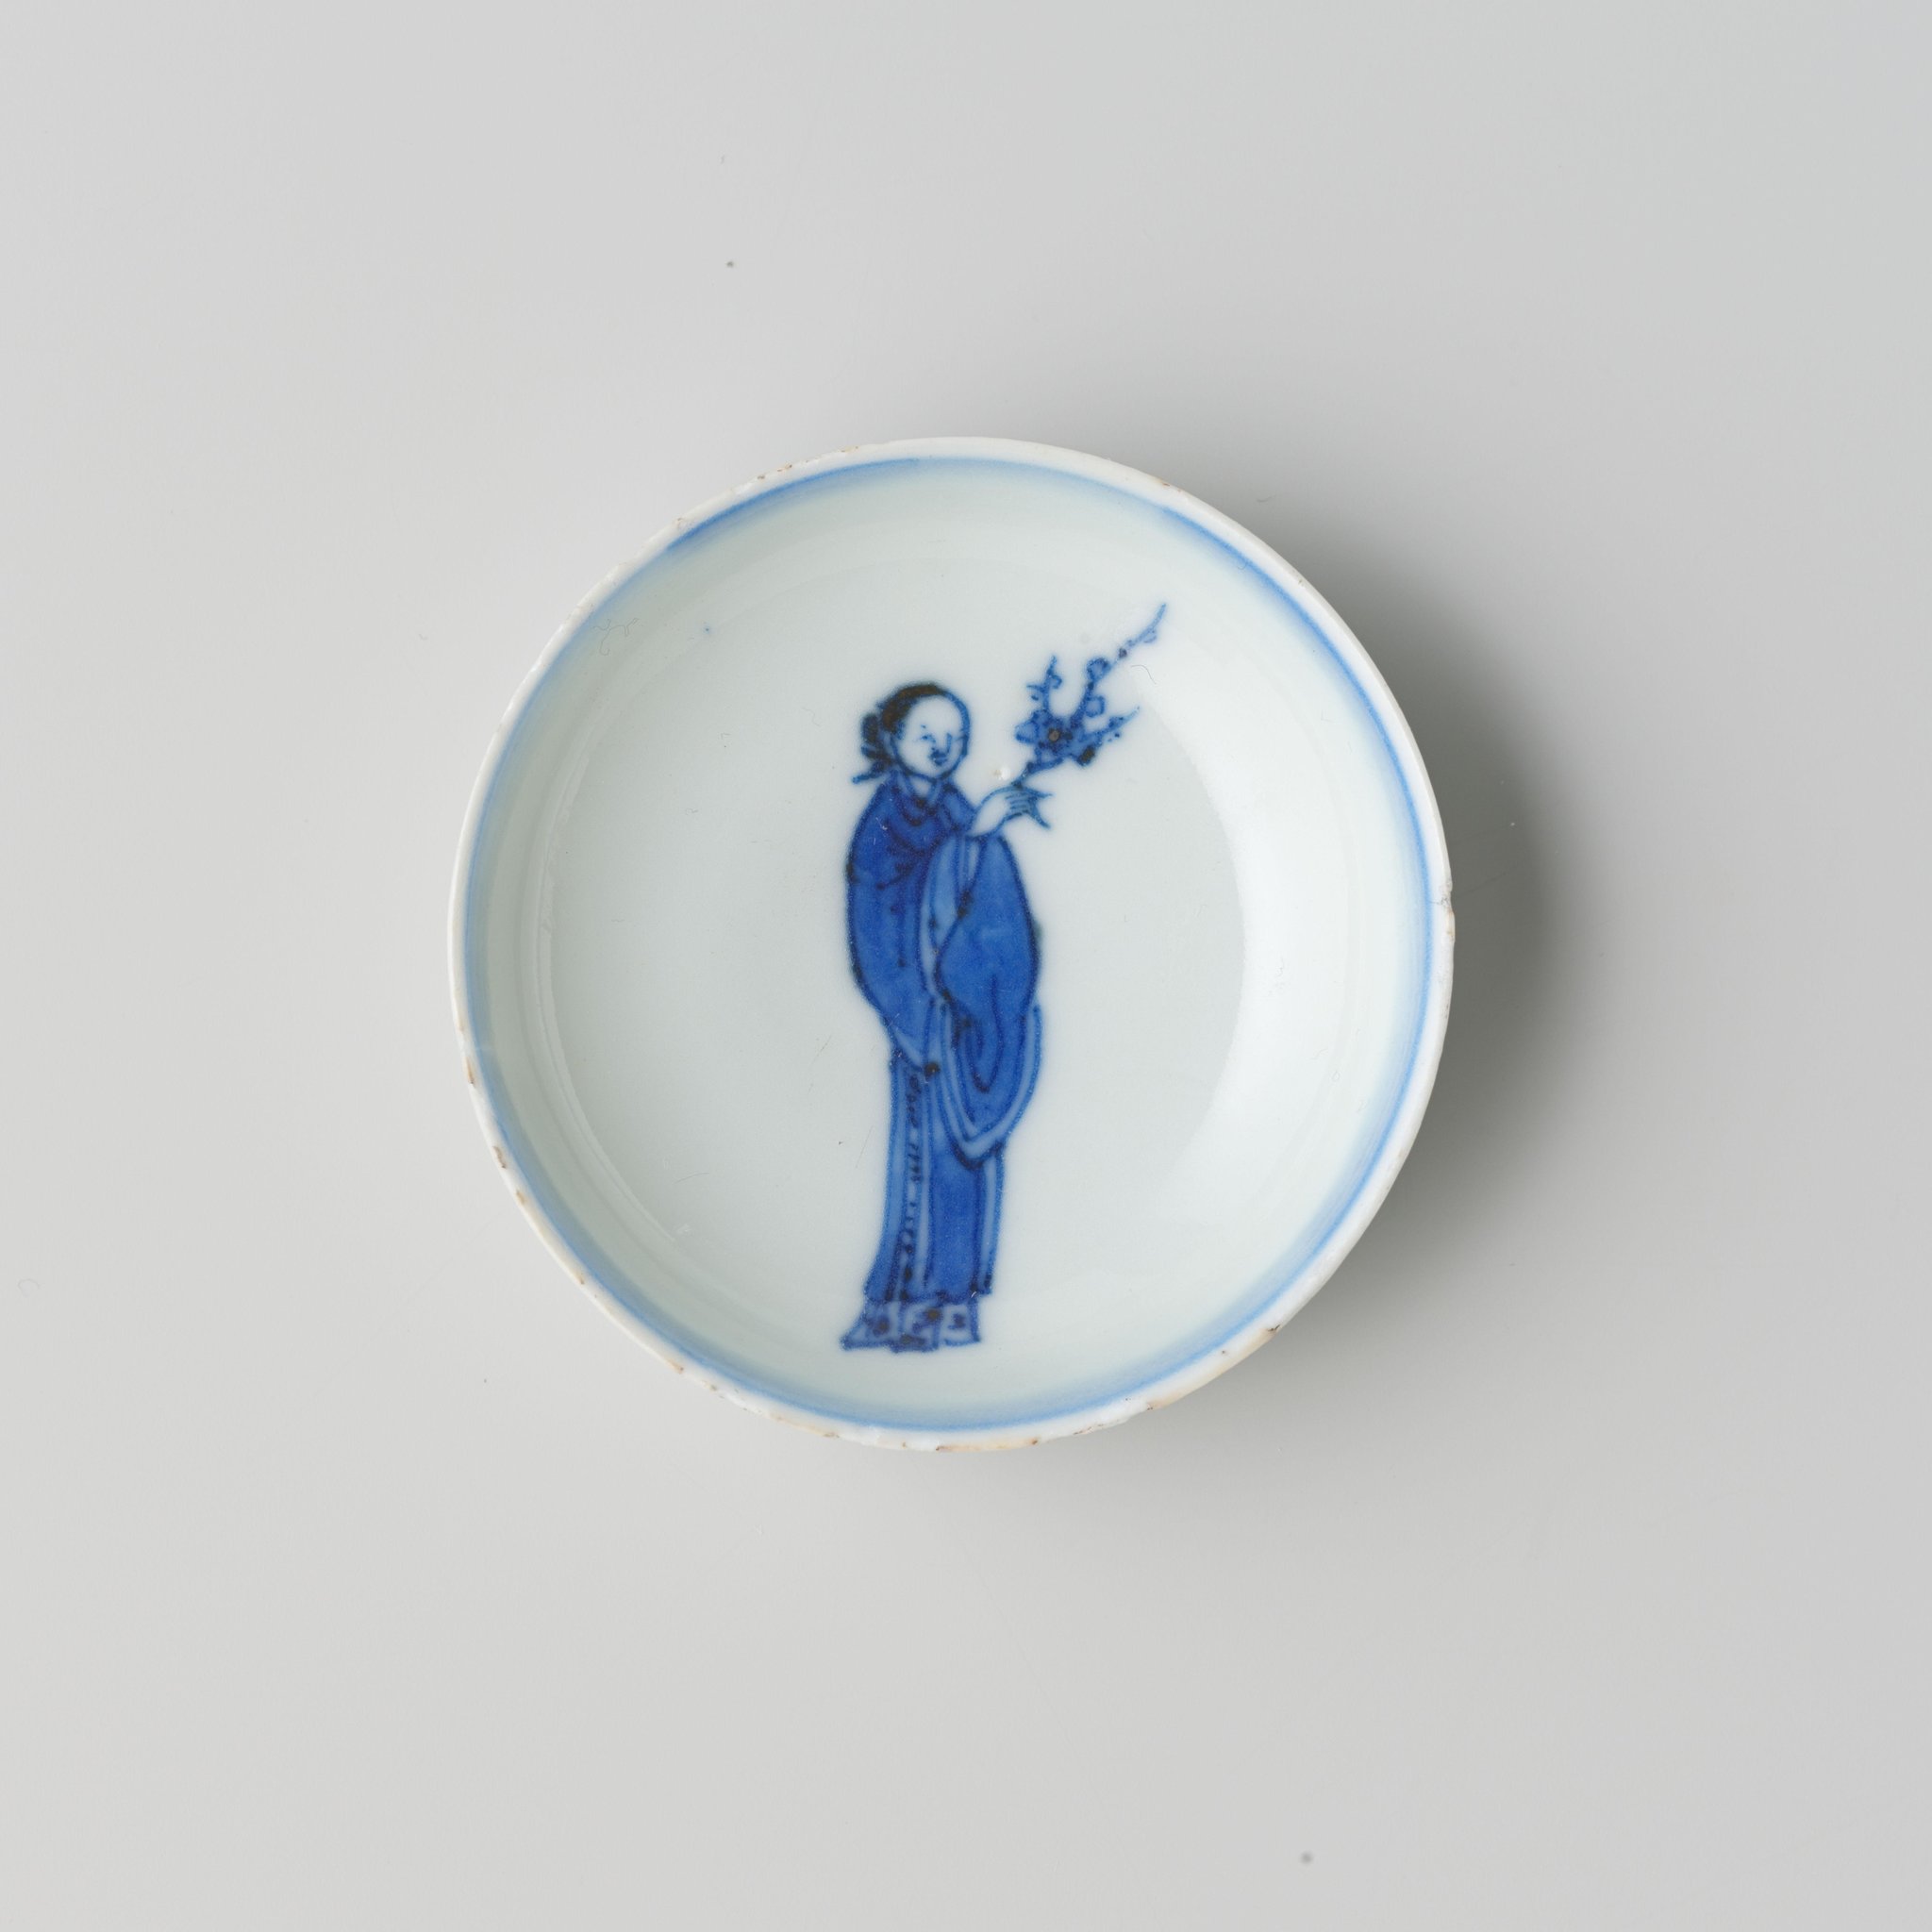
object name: dish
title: Miniature saucer-dish with a woman and flower sprays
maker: Anonymous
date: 1675-1699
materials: cobalt, glaze, paint, porcelain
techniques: firing, turning, vitrification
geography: china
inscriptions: mark: ‘大明成化年製’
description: Miniatuur schaal van porselein, beschilderd in onderglazuur blauw. Op het plat een vrouw (lange lijs) en een bloemtak. Gemerkt op de onderzijde met het zes-karaktermerk van keizer Chenghua. Blauw-wit.